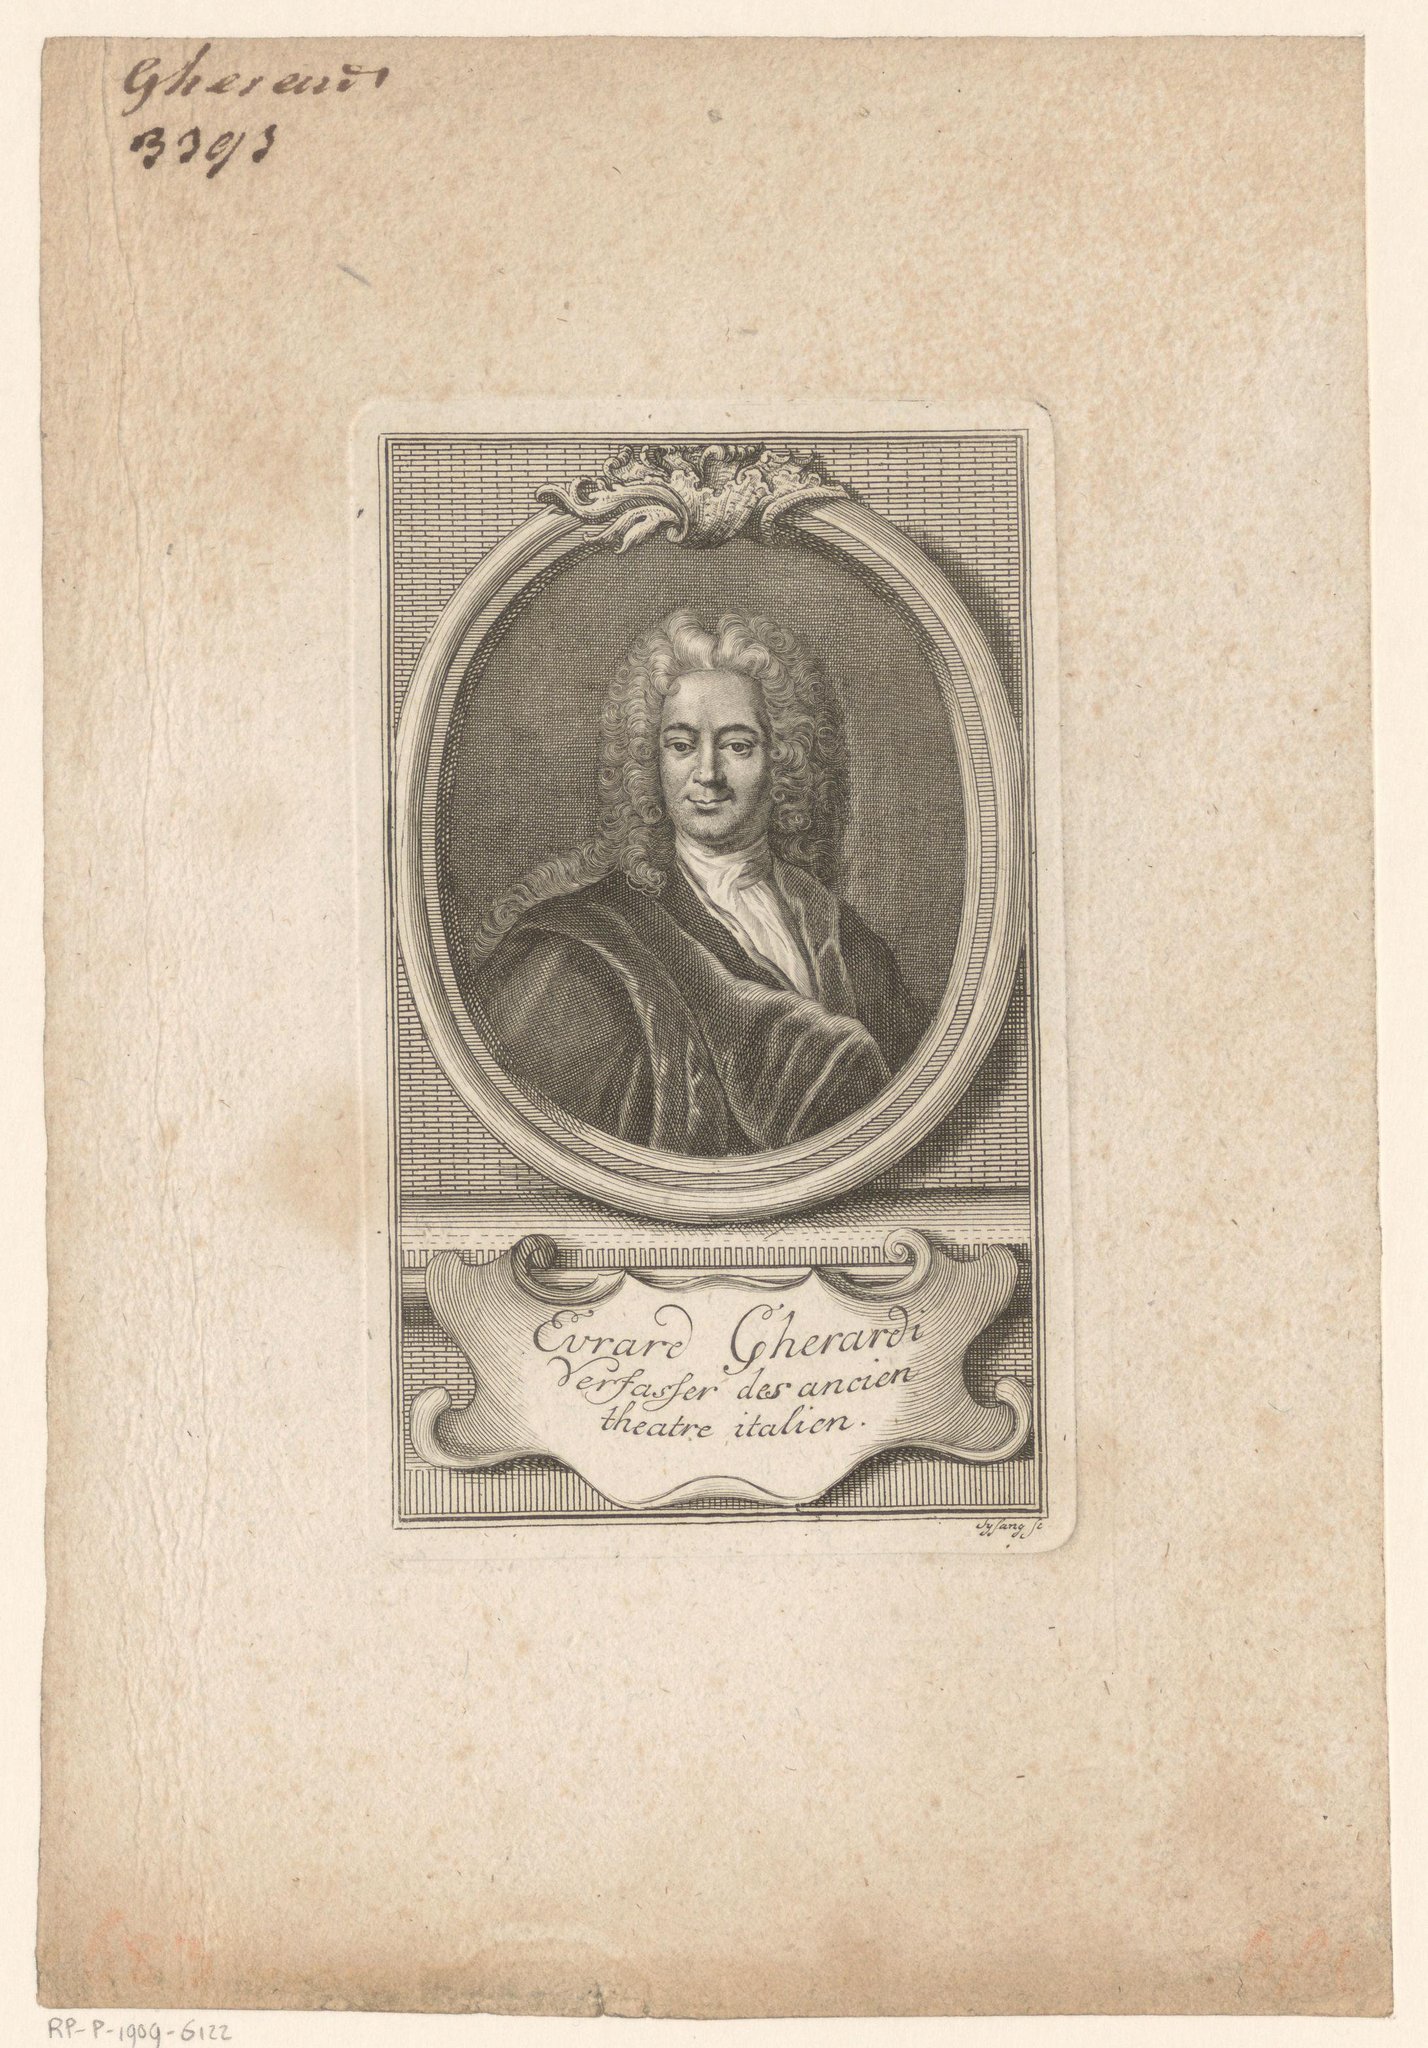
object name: print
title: Portret van Evaristo Gherardi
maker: johann christoph sysang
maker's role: print maker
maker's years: 1703-1757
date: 1713-1757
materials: paper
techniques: engraving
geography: germany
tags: paris, historical persons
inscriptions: collector's mark: Lugt 2228